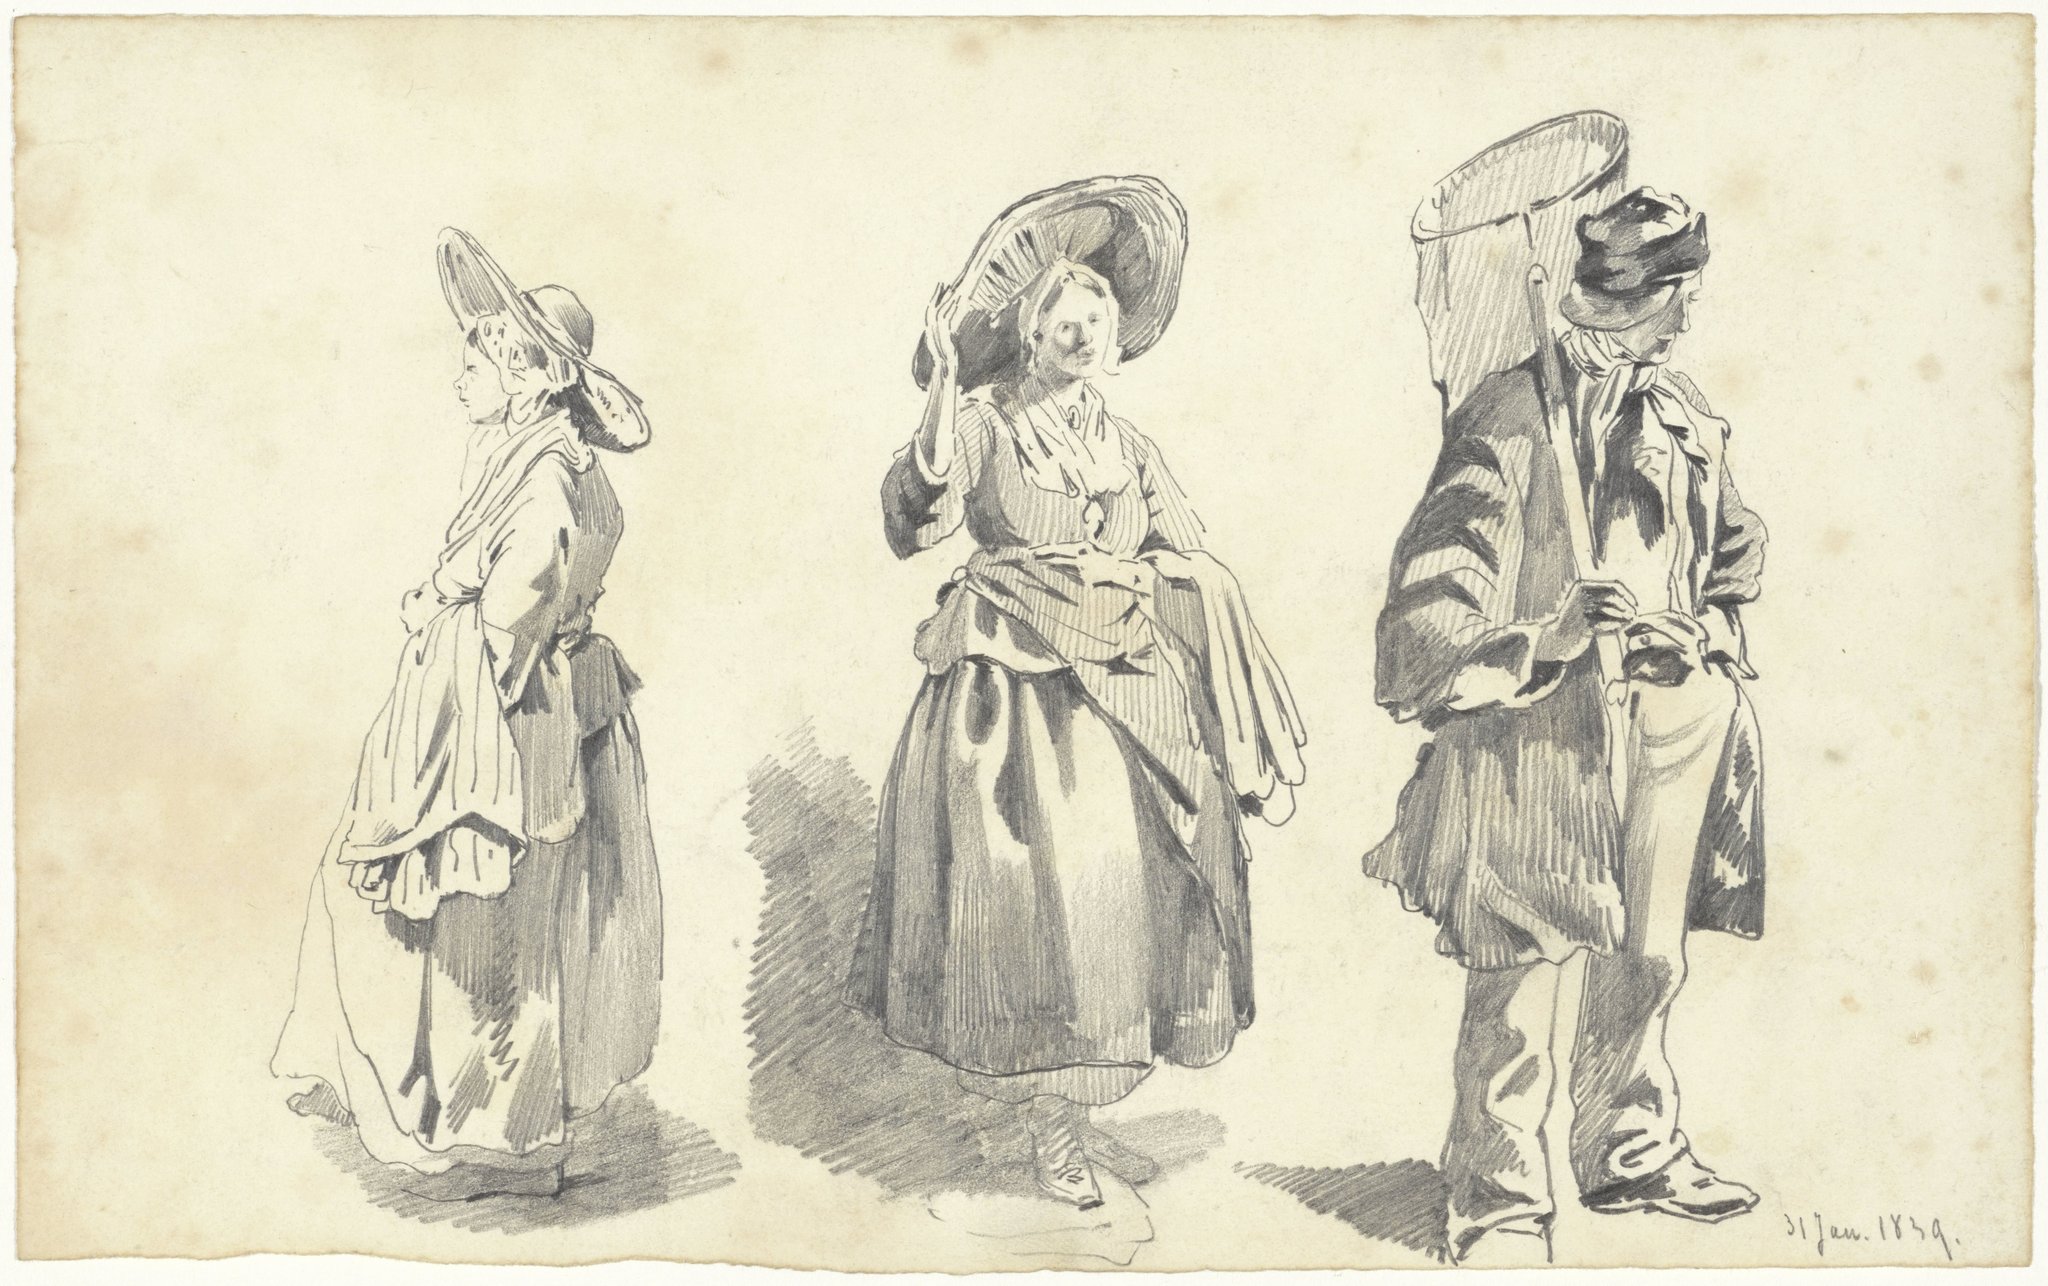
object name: drawing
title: Studies van vrouw met grote hoed en staande visser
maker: pieter van loon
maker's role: draughtsman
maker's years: 1801-1873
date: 1839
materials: paper, pencil